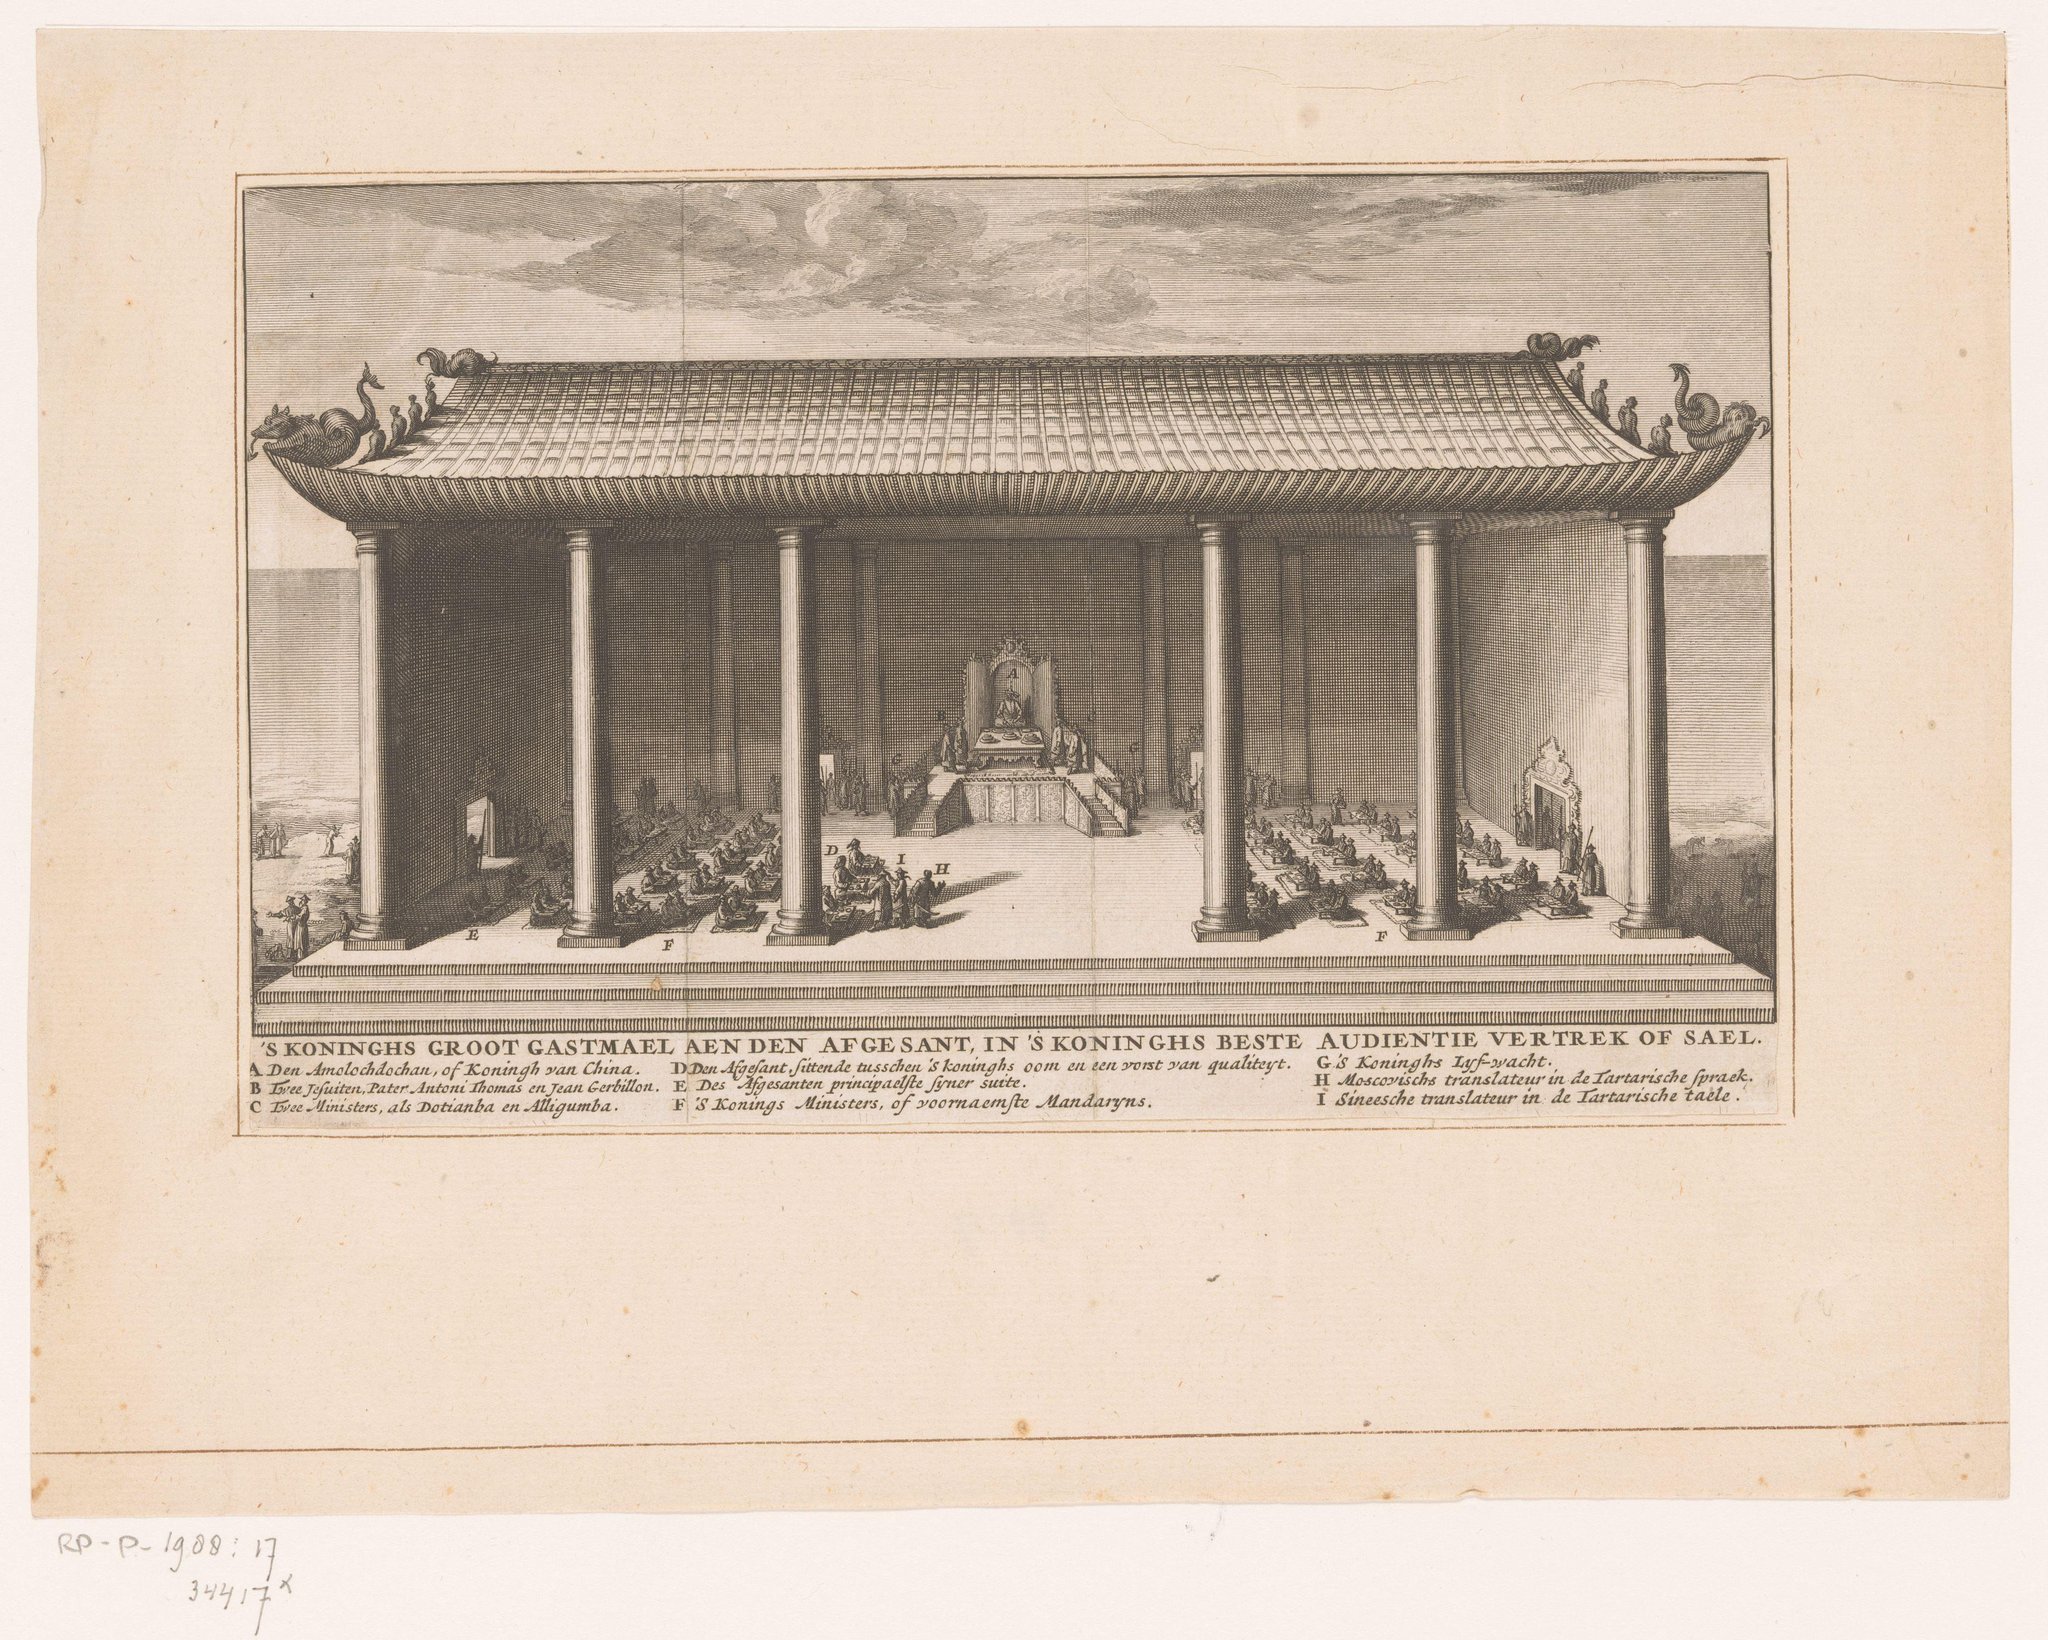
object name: print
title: Banket van de Chinese koning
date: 1710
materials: paper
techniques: engraving, etching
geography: amsterdam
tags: banquet of elegant company, reception ~ ambassador, china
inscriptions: collector's mark: Lugt 2228, collector's mark: Lugt 2760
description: Op een verhoging in het midden zit de Chinese koning, met twee Jezuïeten en twee ministers aan zijn zijde. De diplomaat Eberhardt Isbrant Ides zit op de grond met twee vertalers. Onder de prent een legenda.